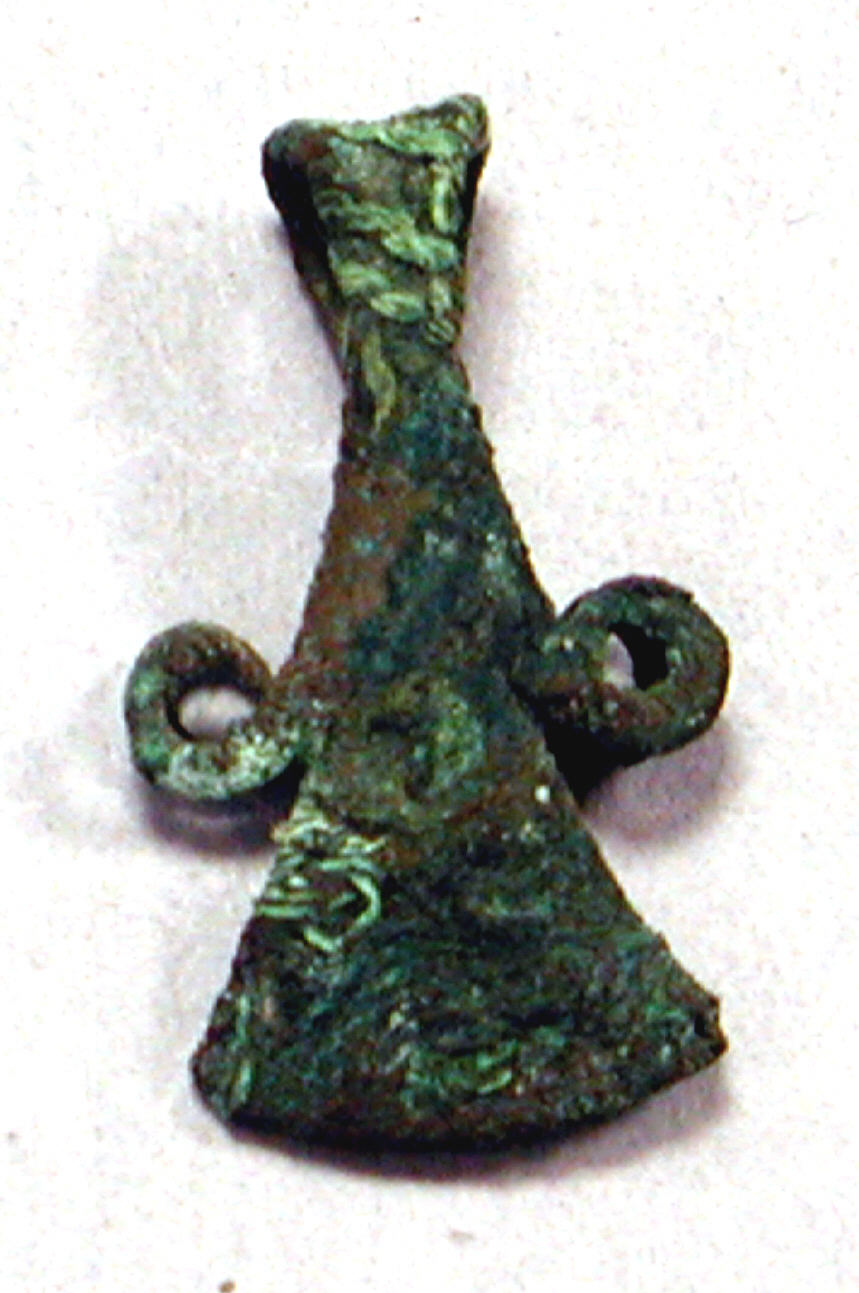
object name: tweezer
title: Copper Tweezers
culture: peruvian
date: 1501-1600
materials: copper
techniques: hammering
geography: peru